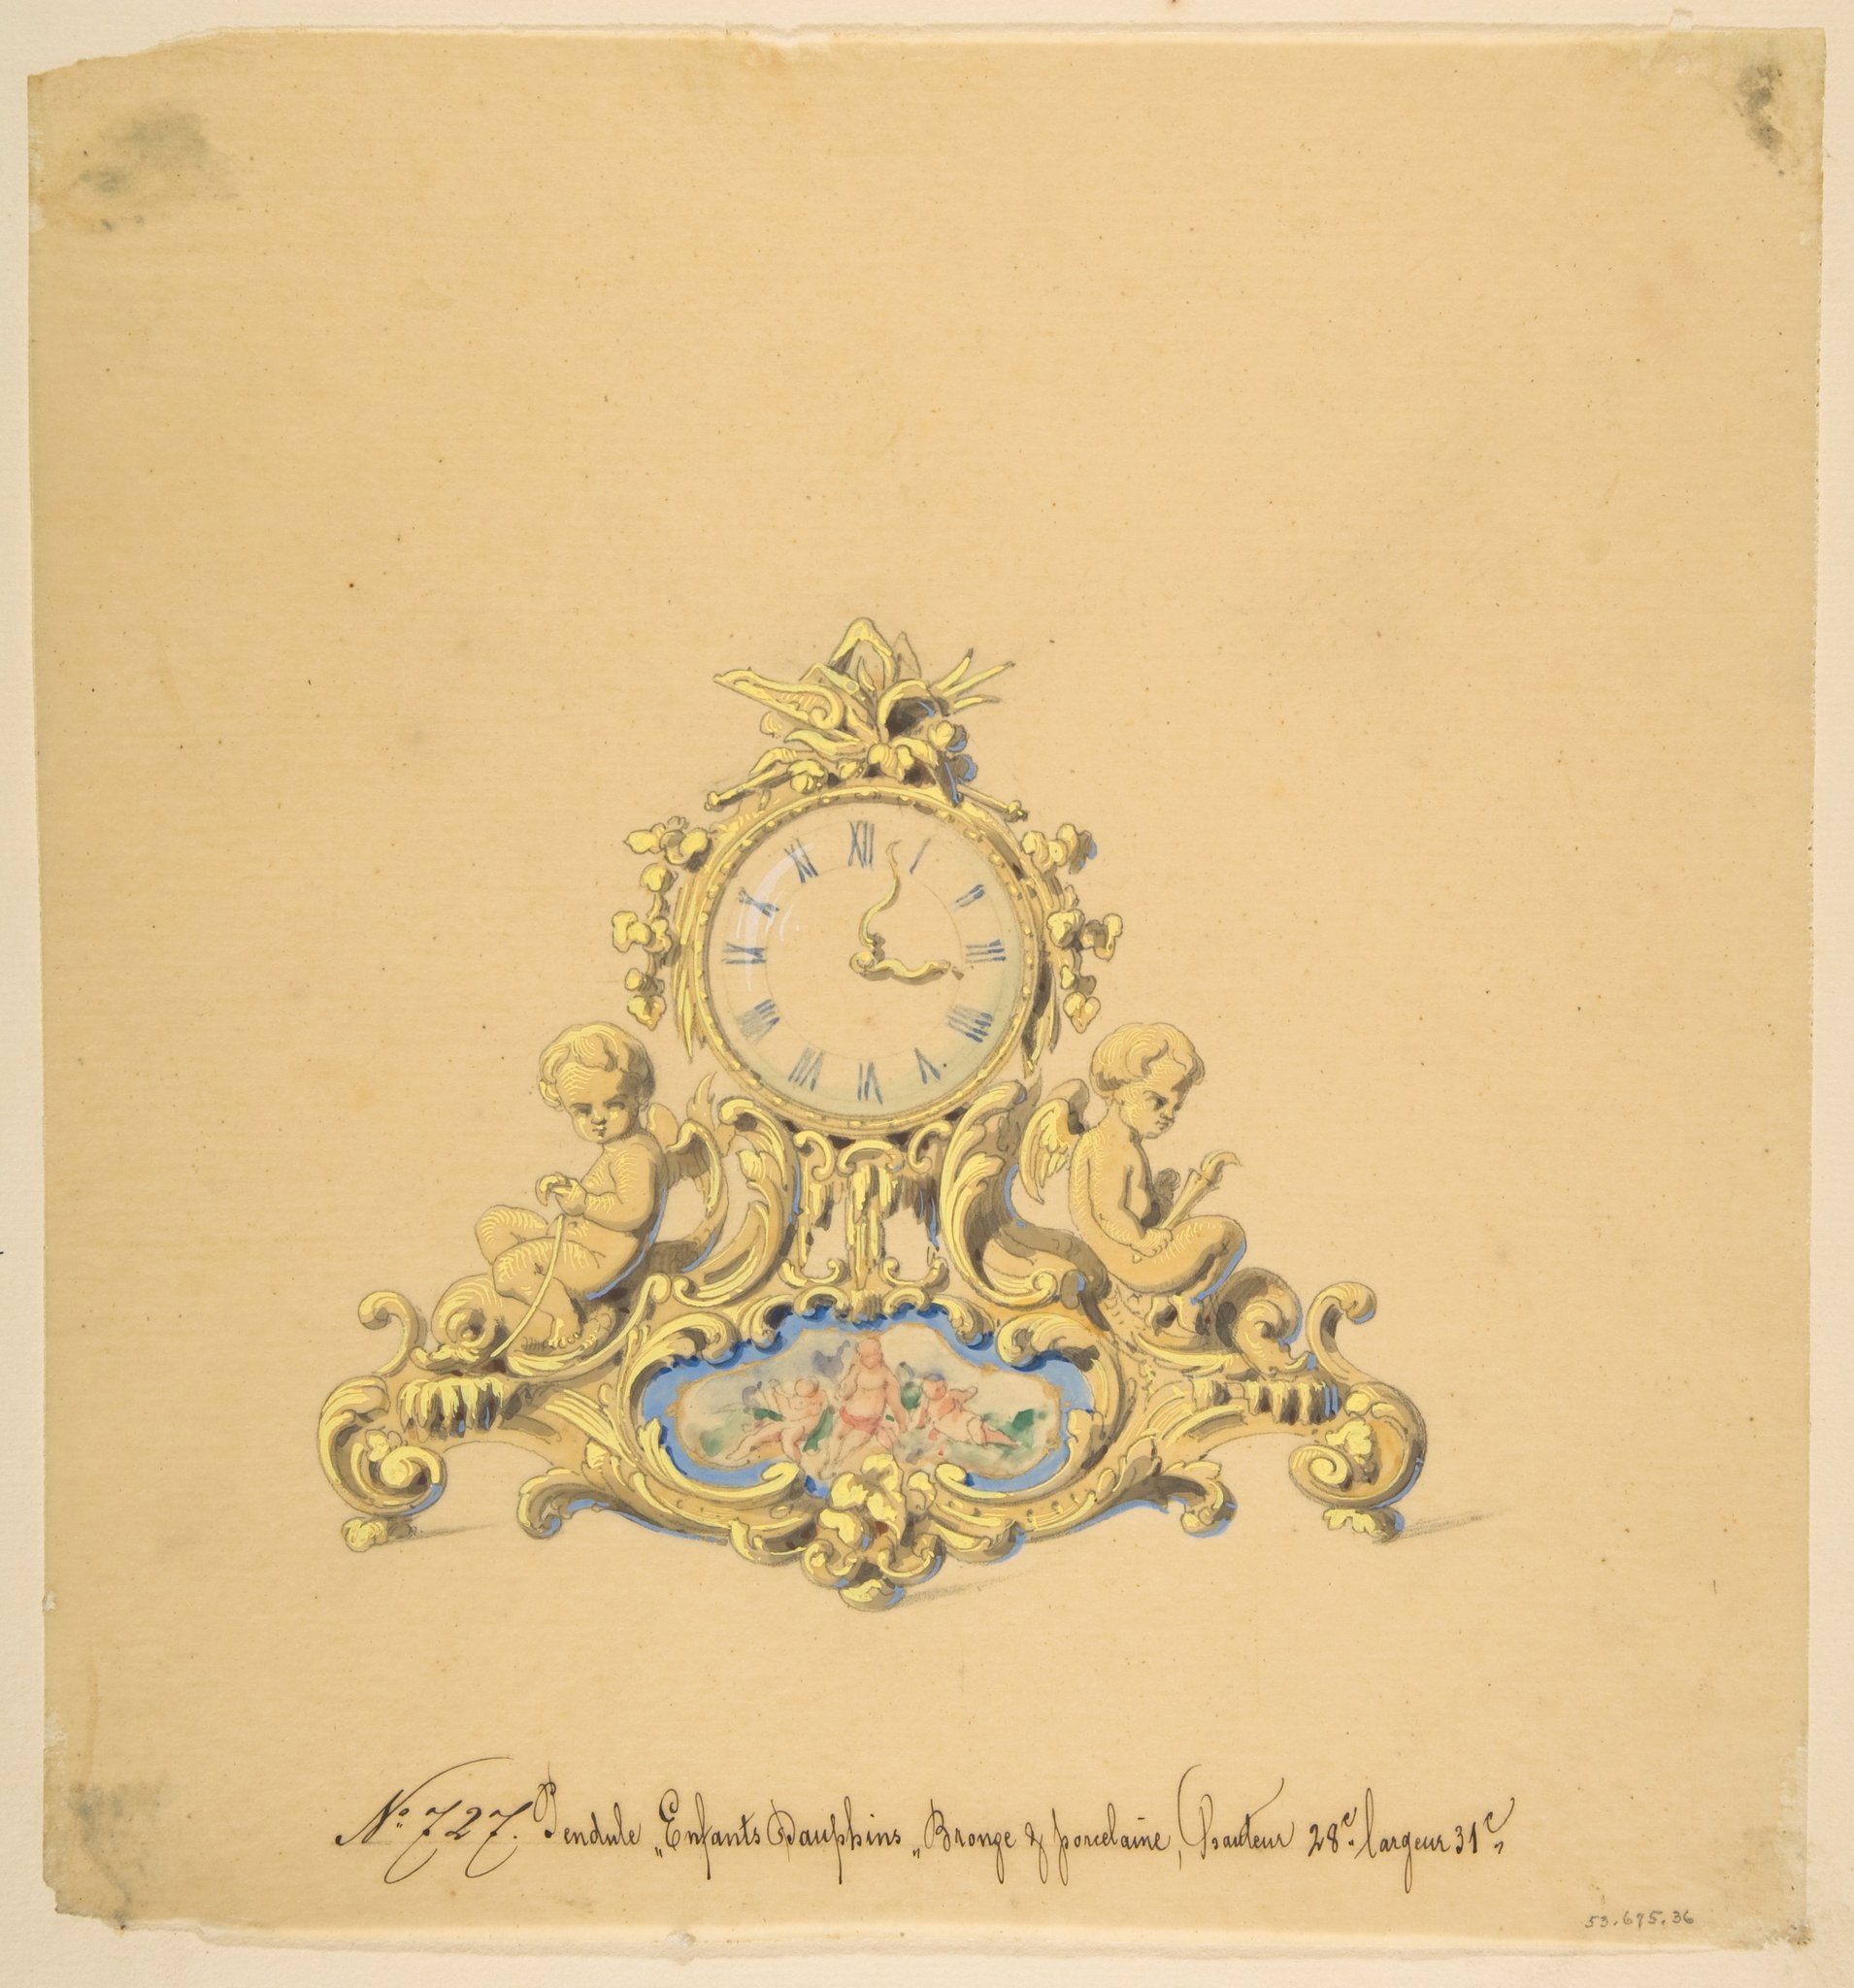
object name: drawing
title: Design for a Clock with Two Cherubs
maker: anonymous, french, 19th century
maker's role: artist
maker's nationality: french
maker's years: 1800-1900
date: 1801-1900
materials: gouache, graphite, ink, watercolor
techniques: brush, pen, wash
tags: clocks